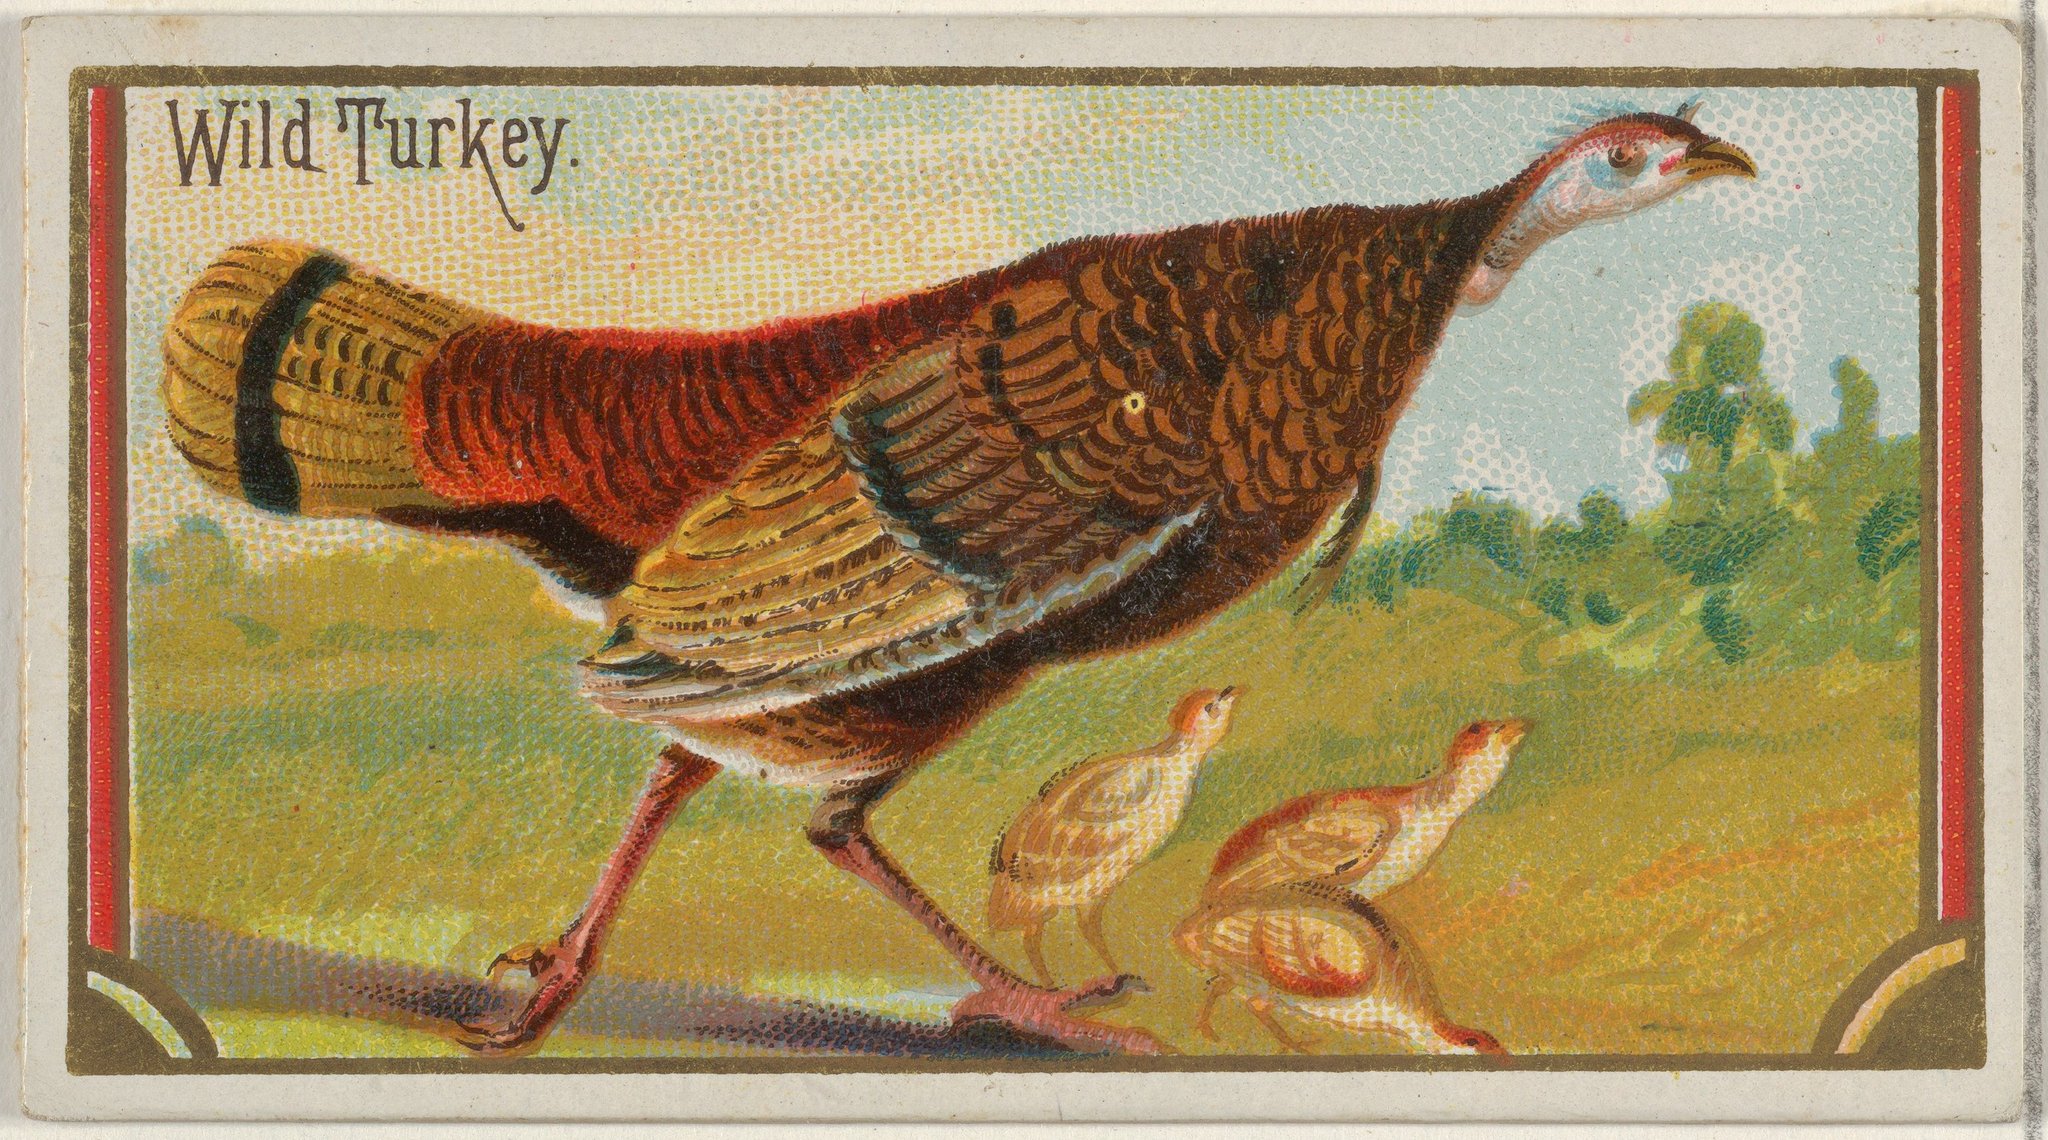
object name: print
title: Wild Turkey, from the Game Birds series (N13) for Allen & Ginter Cigarettes Brands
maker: allen & ginter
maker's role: publisher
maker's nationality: american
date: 1889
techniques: color lithograph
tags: turkeys